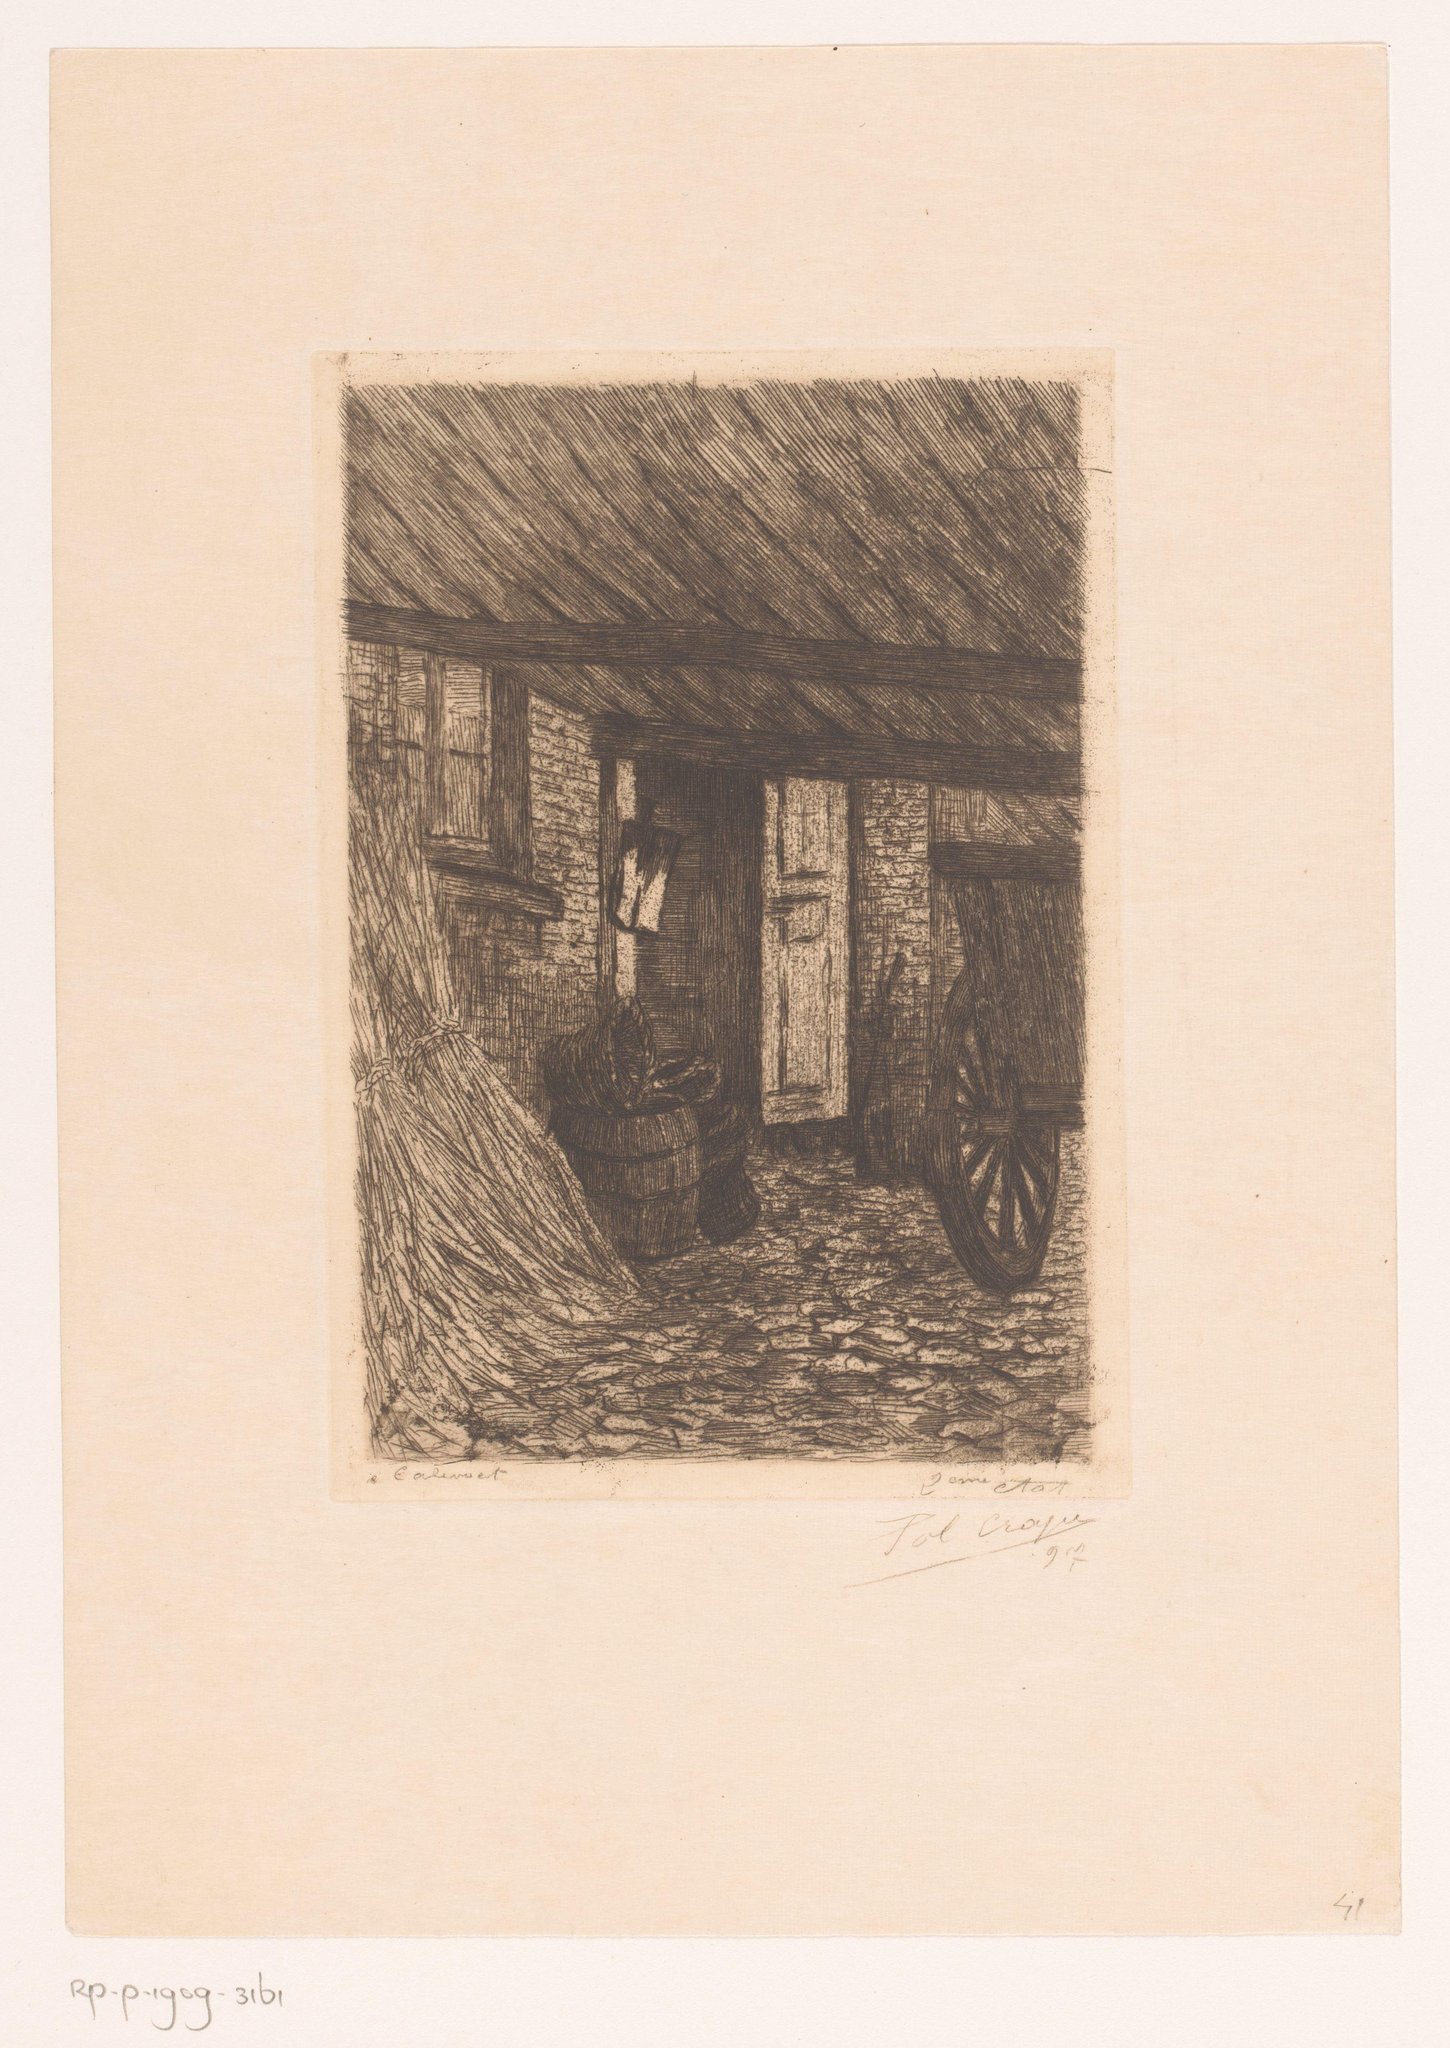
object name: print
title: Calevoet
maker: pol craps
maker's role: print maker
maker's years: 1877-1939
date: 1897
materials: paper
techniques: drypoint, etching, intaglio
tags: barn, (farm) wagon, freight wagon, cart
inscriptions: collector's mark: Lugt 2228, annotation: ‘2eme etat’